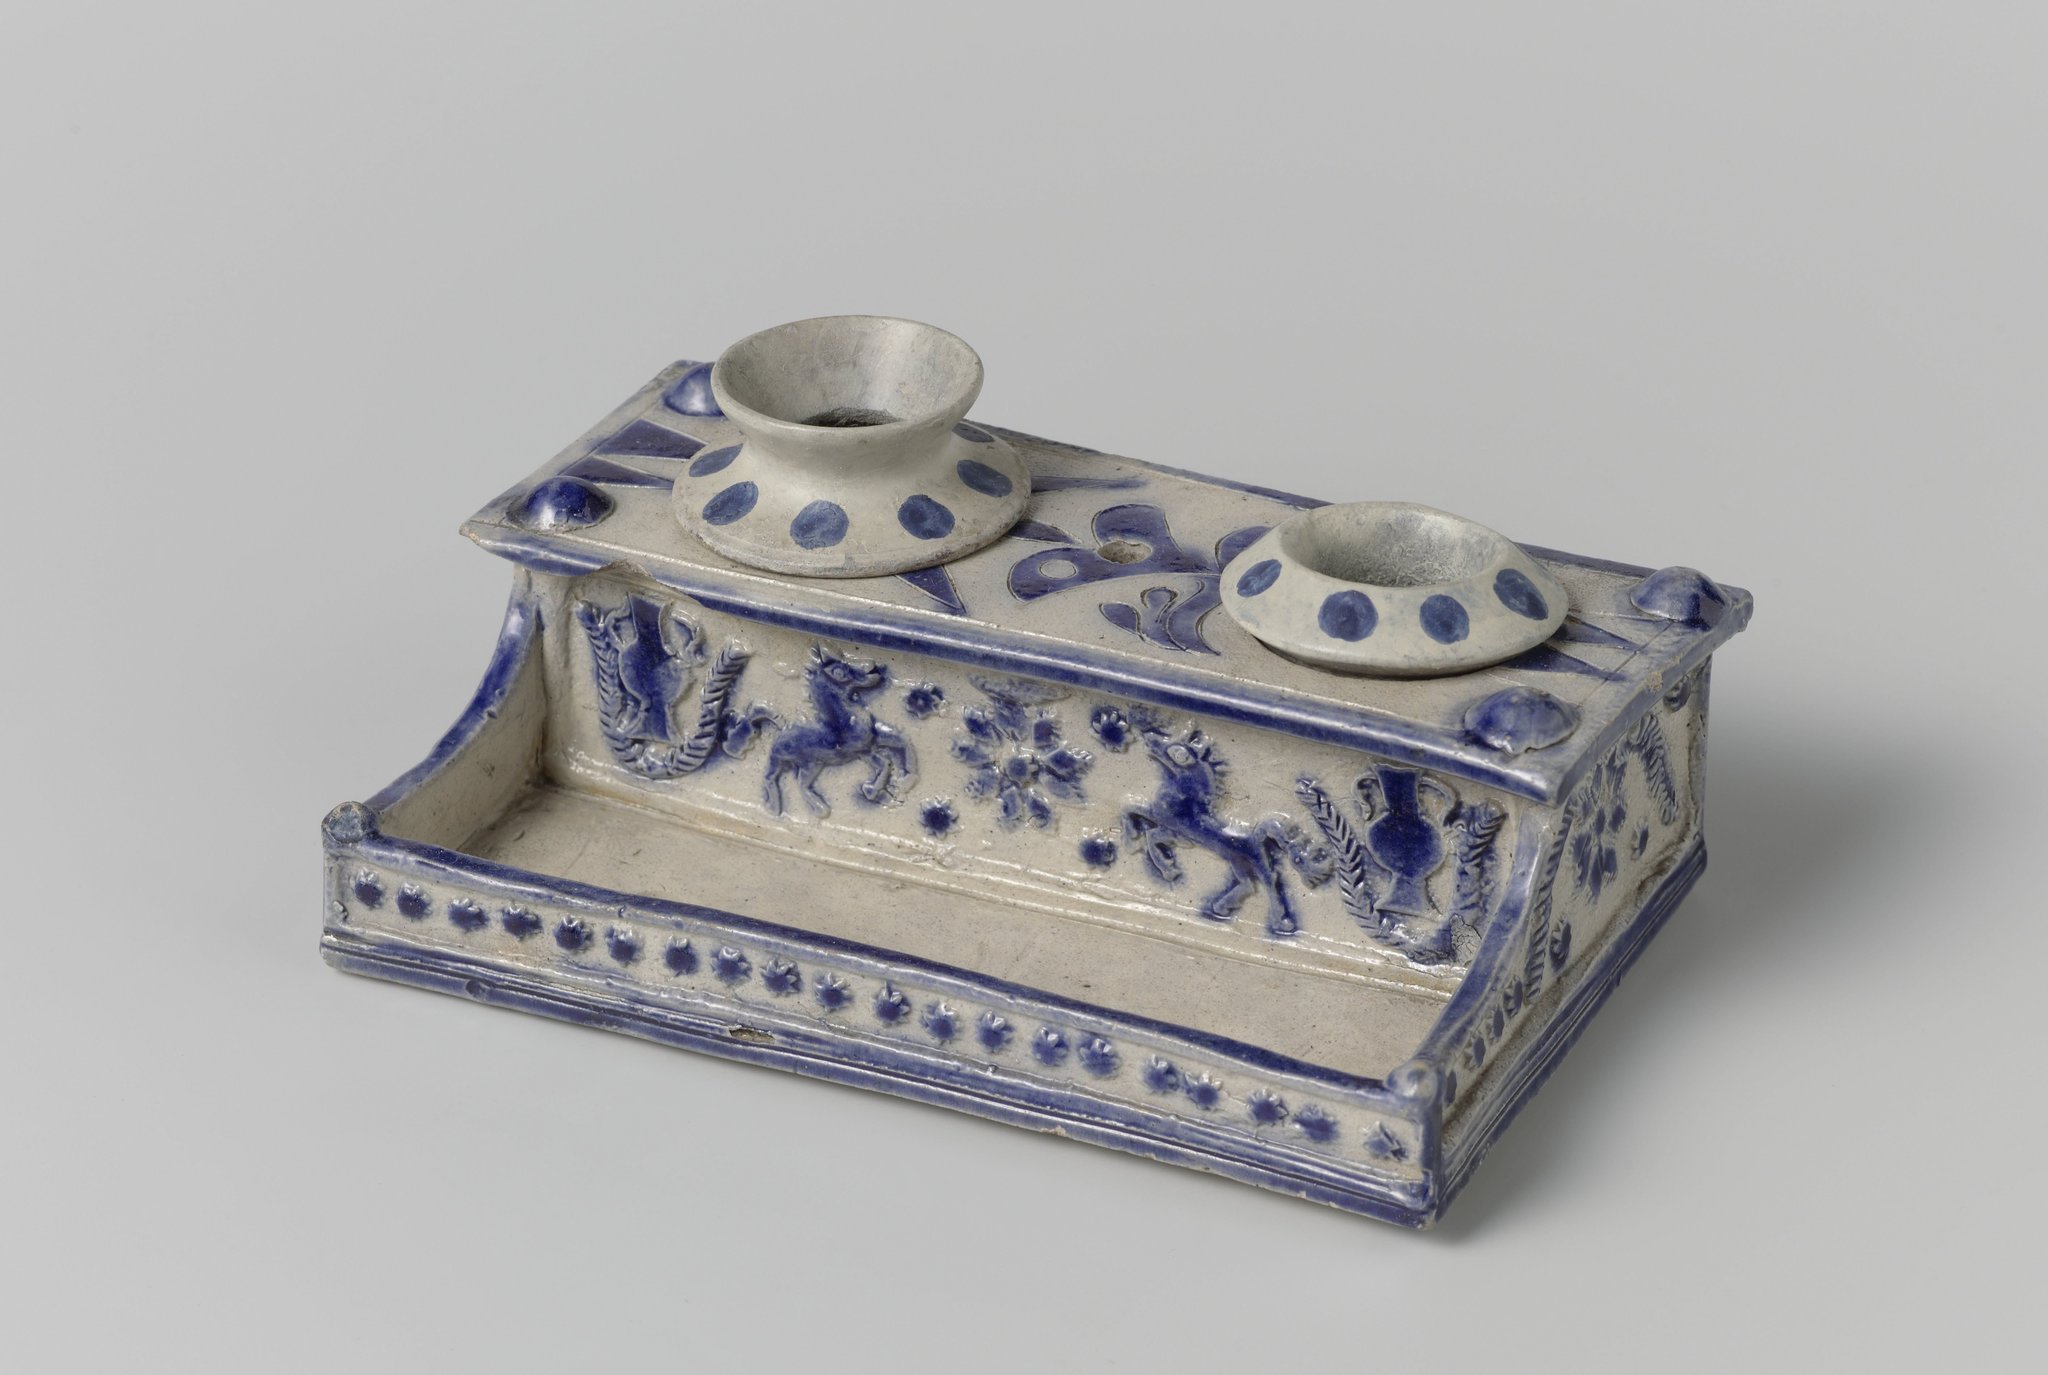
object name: inkstand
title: Ink stand with horses, vases and flowers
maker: Anonymous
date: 1750-1799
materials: cobalt, glaze, stoneware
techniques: firing, forming, relief, turning, vitrification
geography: westerwald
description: Inkstel van steengoed met een pennenbak en twee houders voor de inktpot en de zandstrooier. Gedeeltelijk bedekt met kobaltblauw. De voor- en achterzijde met een reliëfdecoratie van een gedrukte en opgelegde bloem geflankeerd door steigerende paarden en twee-orige vazen omgeven door een festoen. Op de bovenzijde een ingegrifte, gestileerde bloeiende plant. Op elke hoek een gemodelleerde 'klinknagel'. Westerwald.